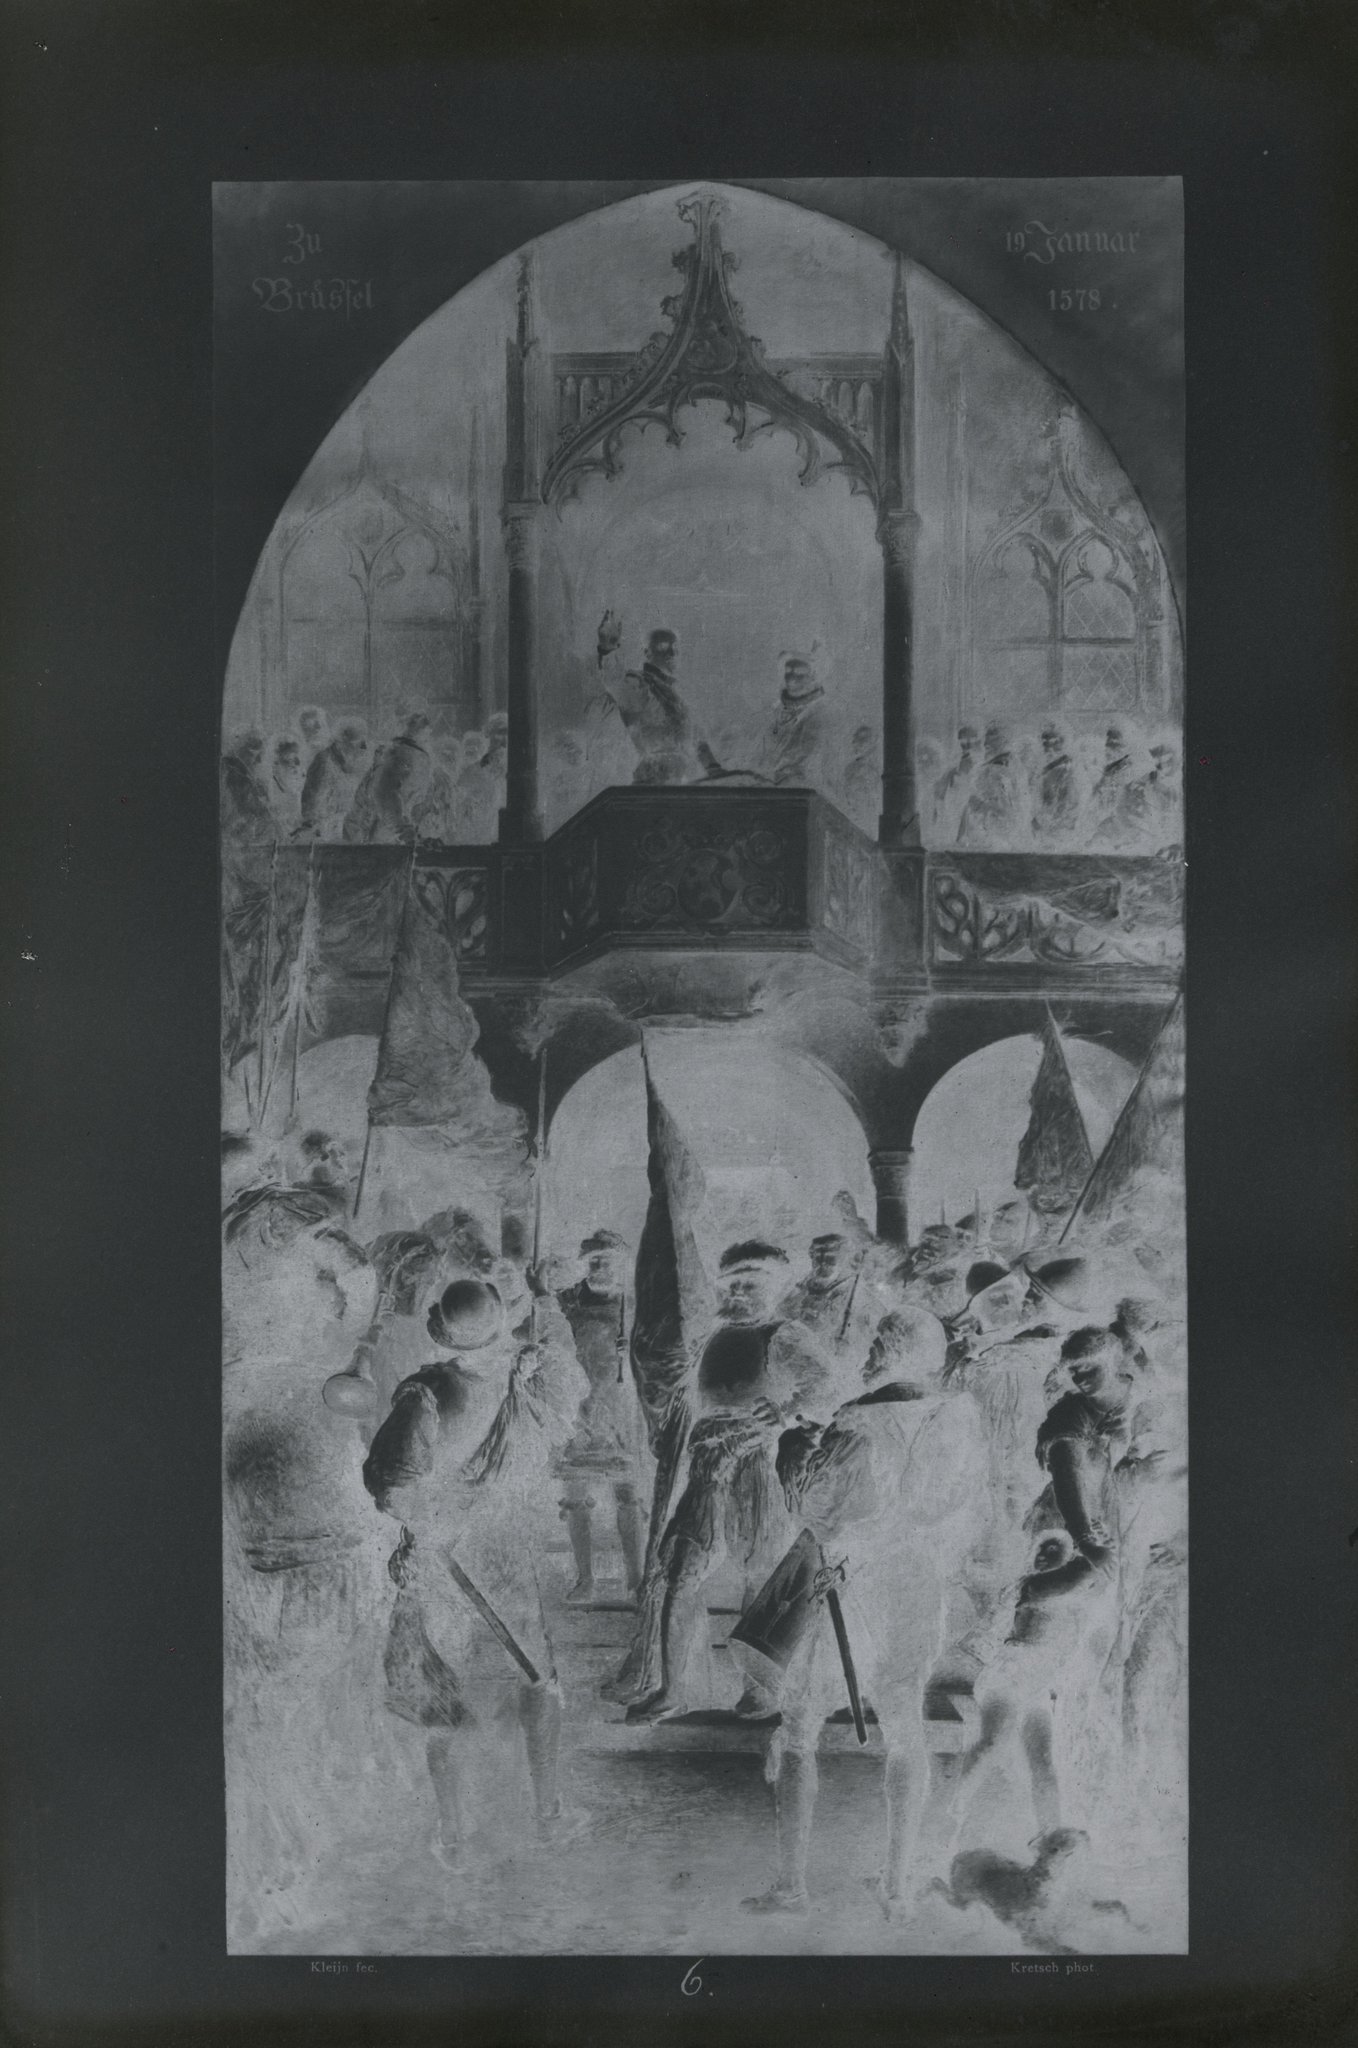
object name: reproduction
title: Zu Brussel, 19 Januar 1578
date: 1865-1900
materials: glass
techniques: collodion process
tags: ceremonial celebration of installation of a ruler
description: Onderdeel van een groep glasnegatieven uit de nalatenschap van de schilder Laurens Lodewijk Kleijn, met stillevens, portretten, zelfportretten en kunstreproducties.